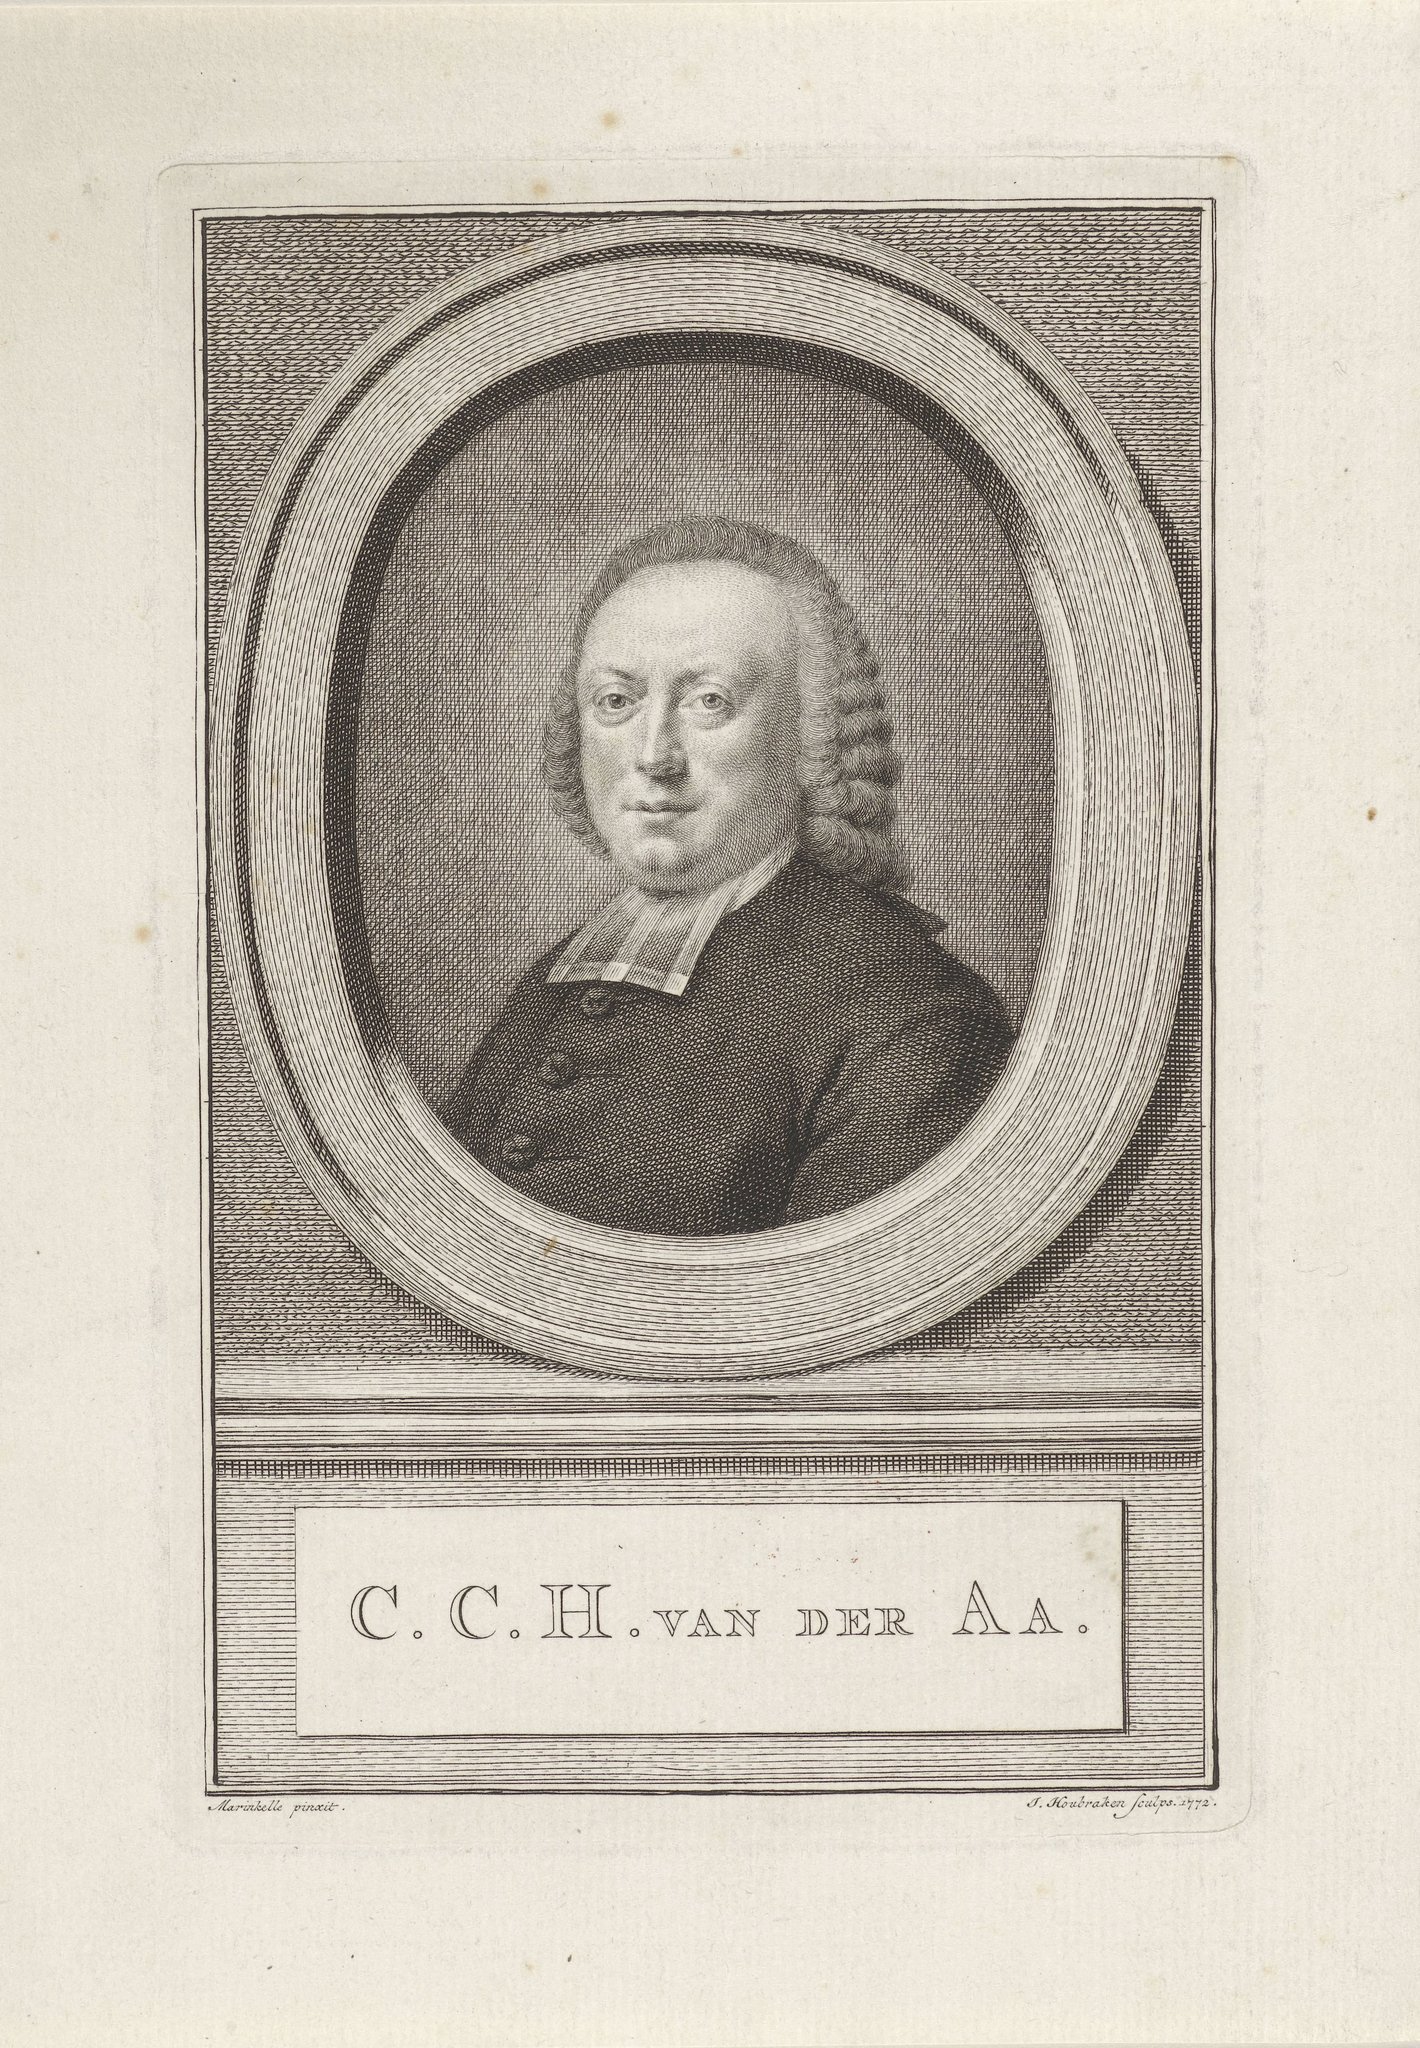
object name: print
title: C.C.H. van der Aa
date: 1772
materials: paper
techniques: engraving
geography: amsterdam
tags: haarlem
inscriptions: collector's mark: Lugt 240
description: Buste naar links van Christianus Carolus Henricus van der Aa in een ovaal. Onder het portret zijn naam.